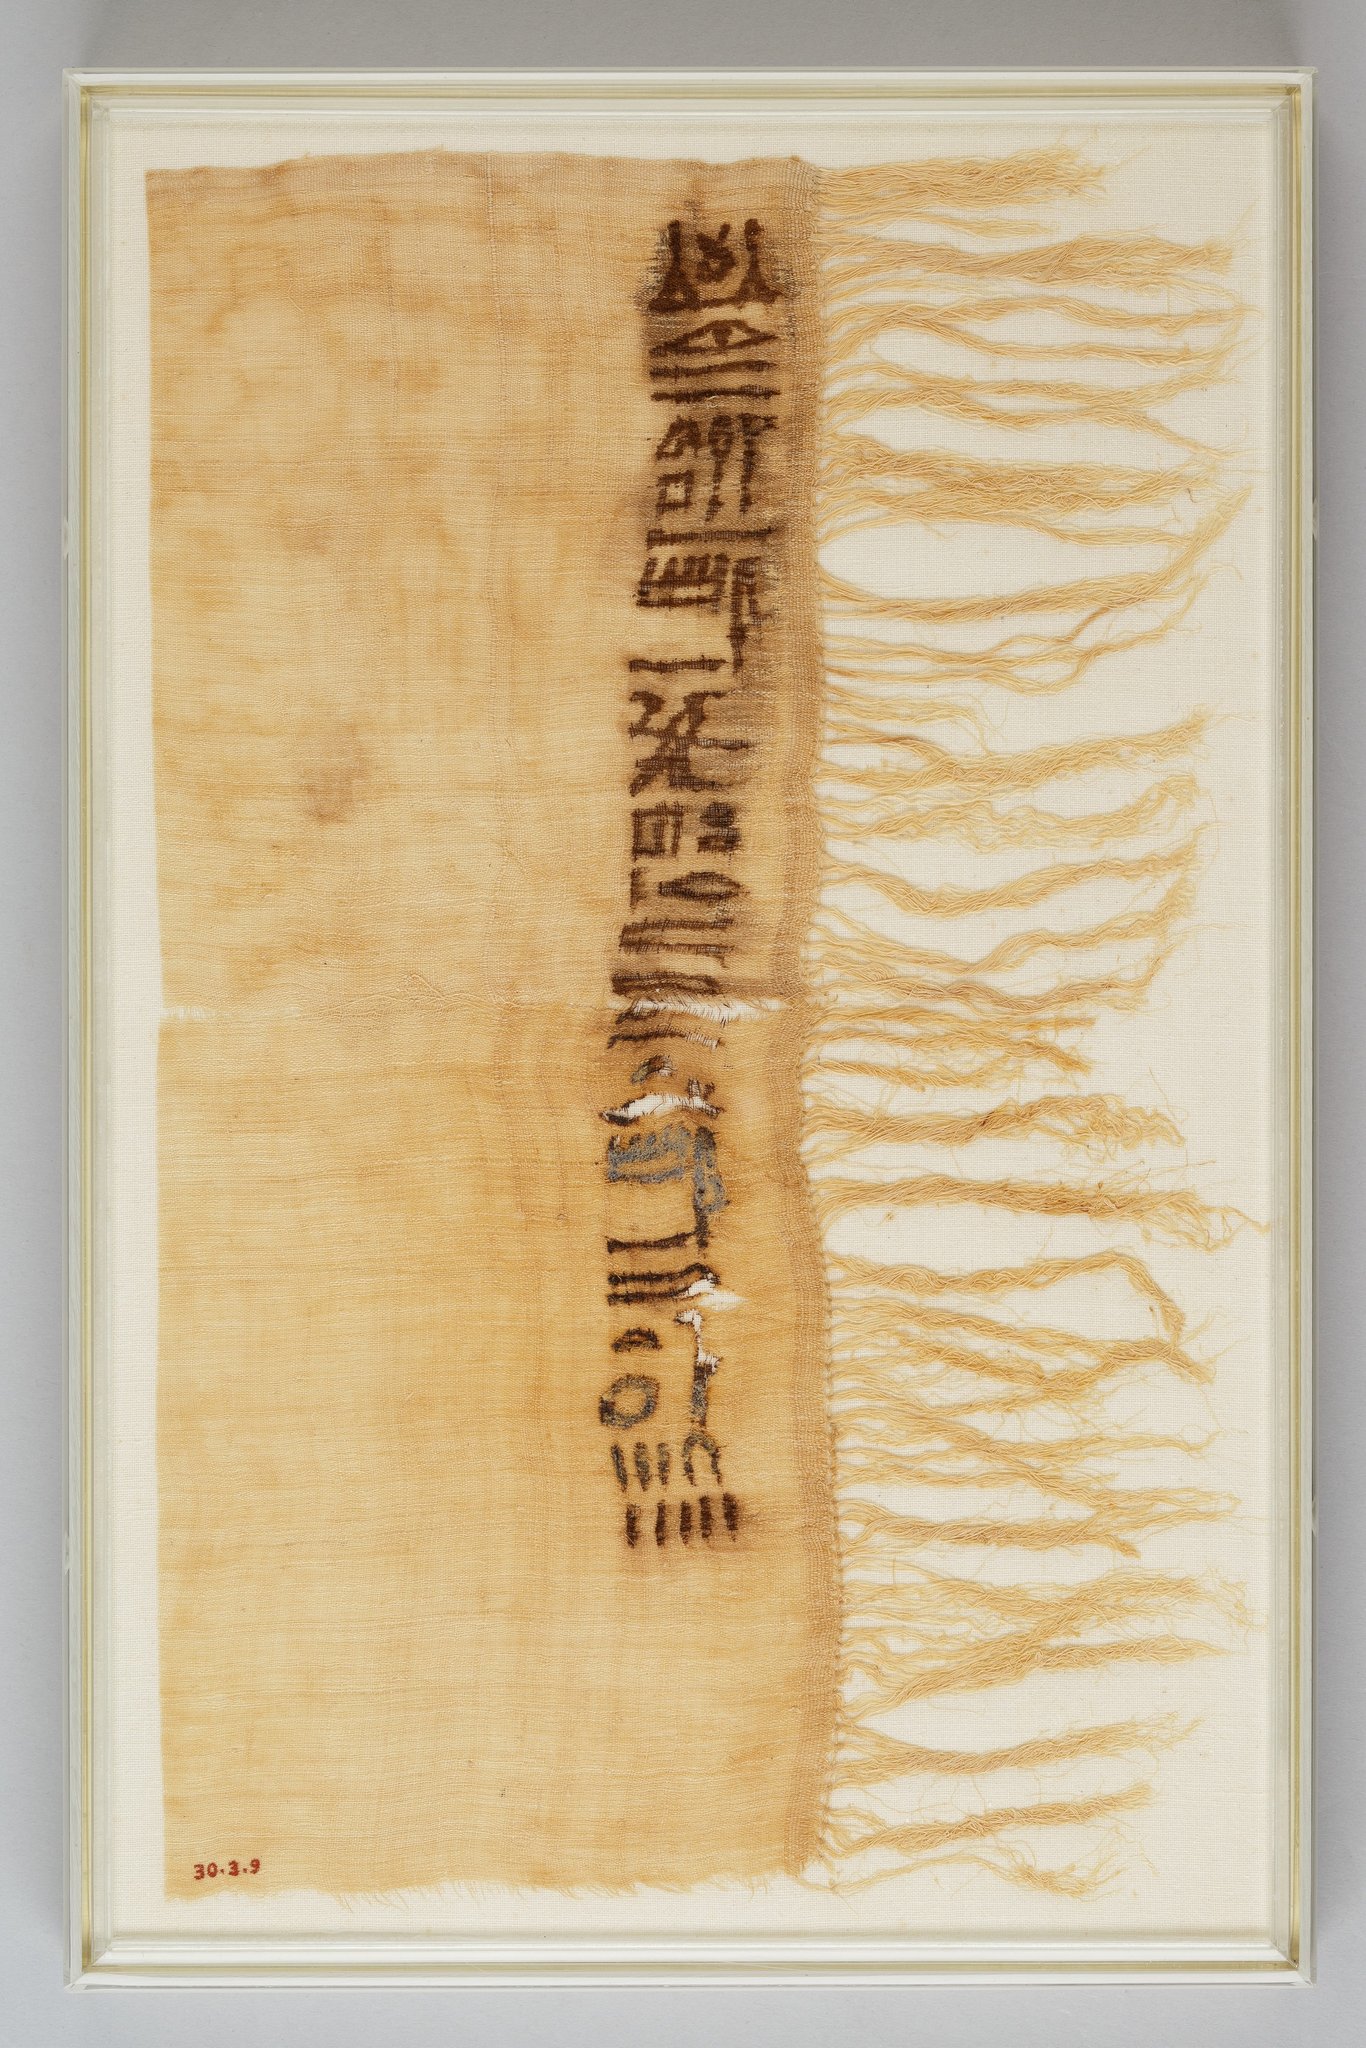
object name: linen mark, masaharta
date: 1051 BCE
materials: linen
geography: egypt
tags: hieroglyphs